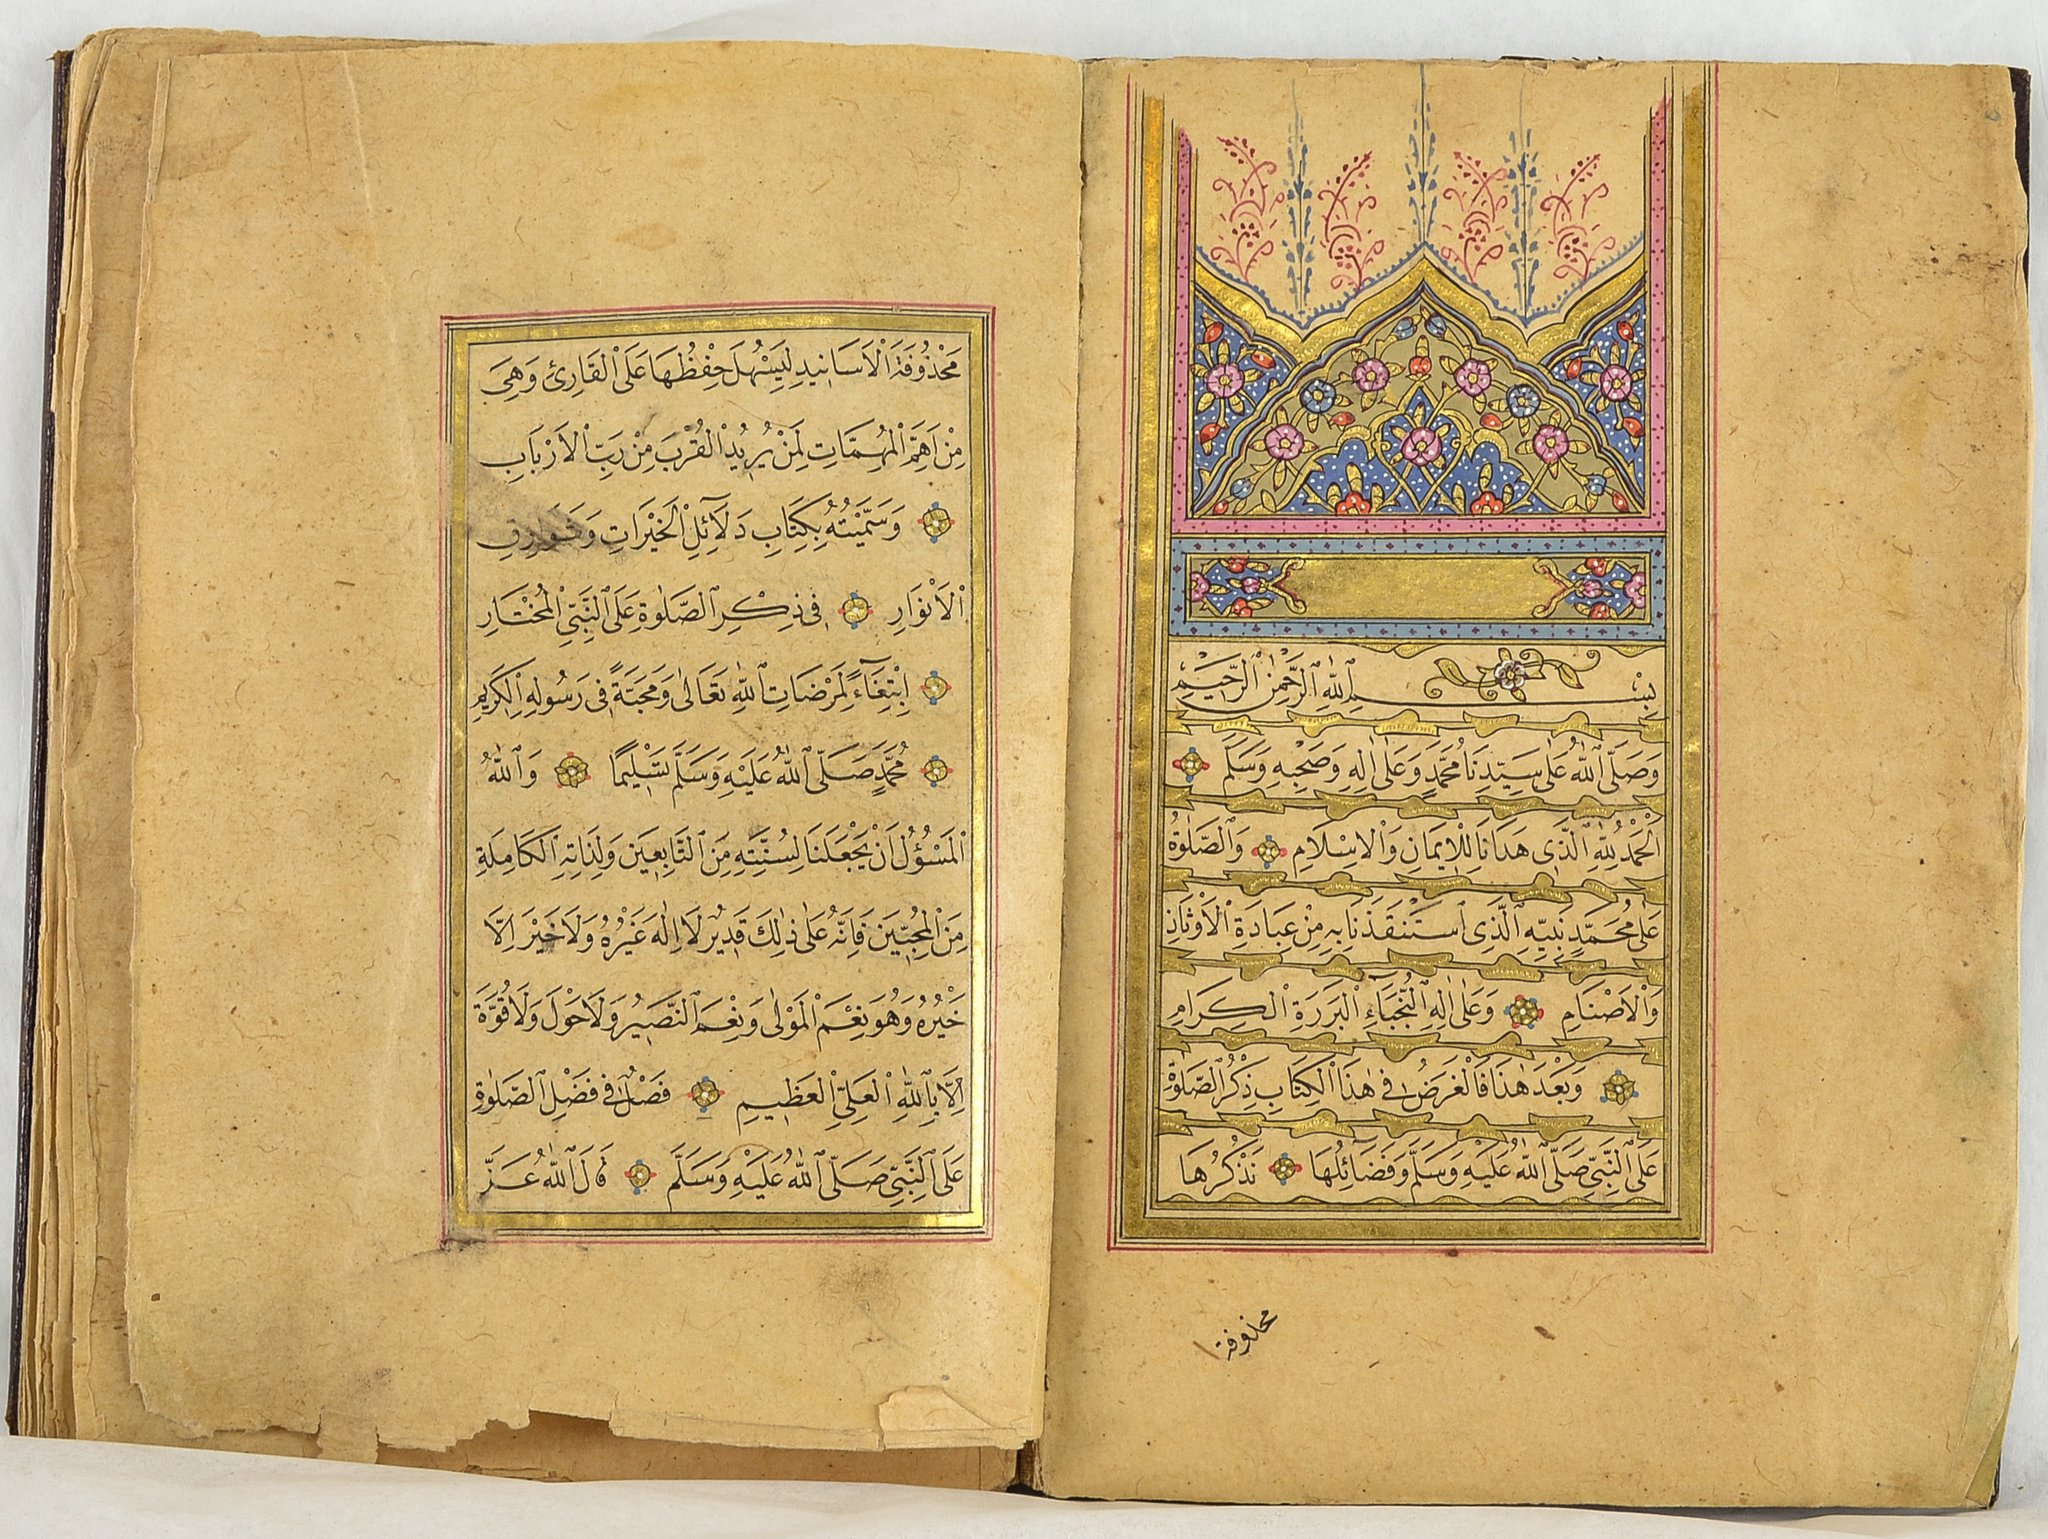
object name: non illustrated manuscript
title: Fragment of a Qur'an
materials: gold, ink, paper, watercolor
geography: lebanon